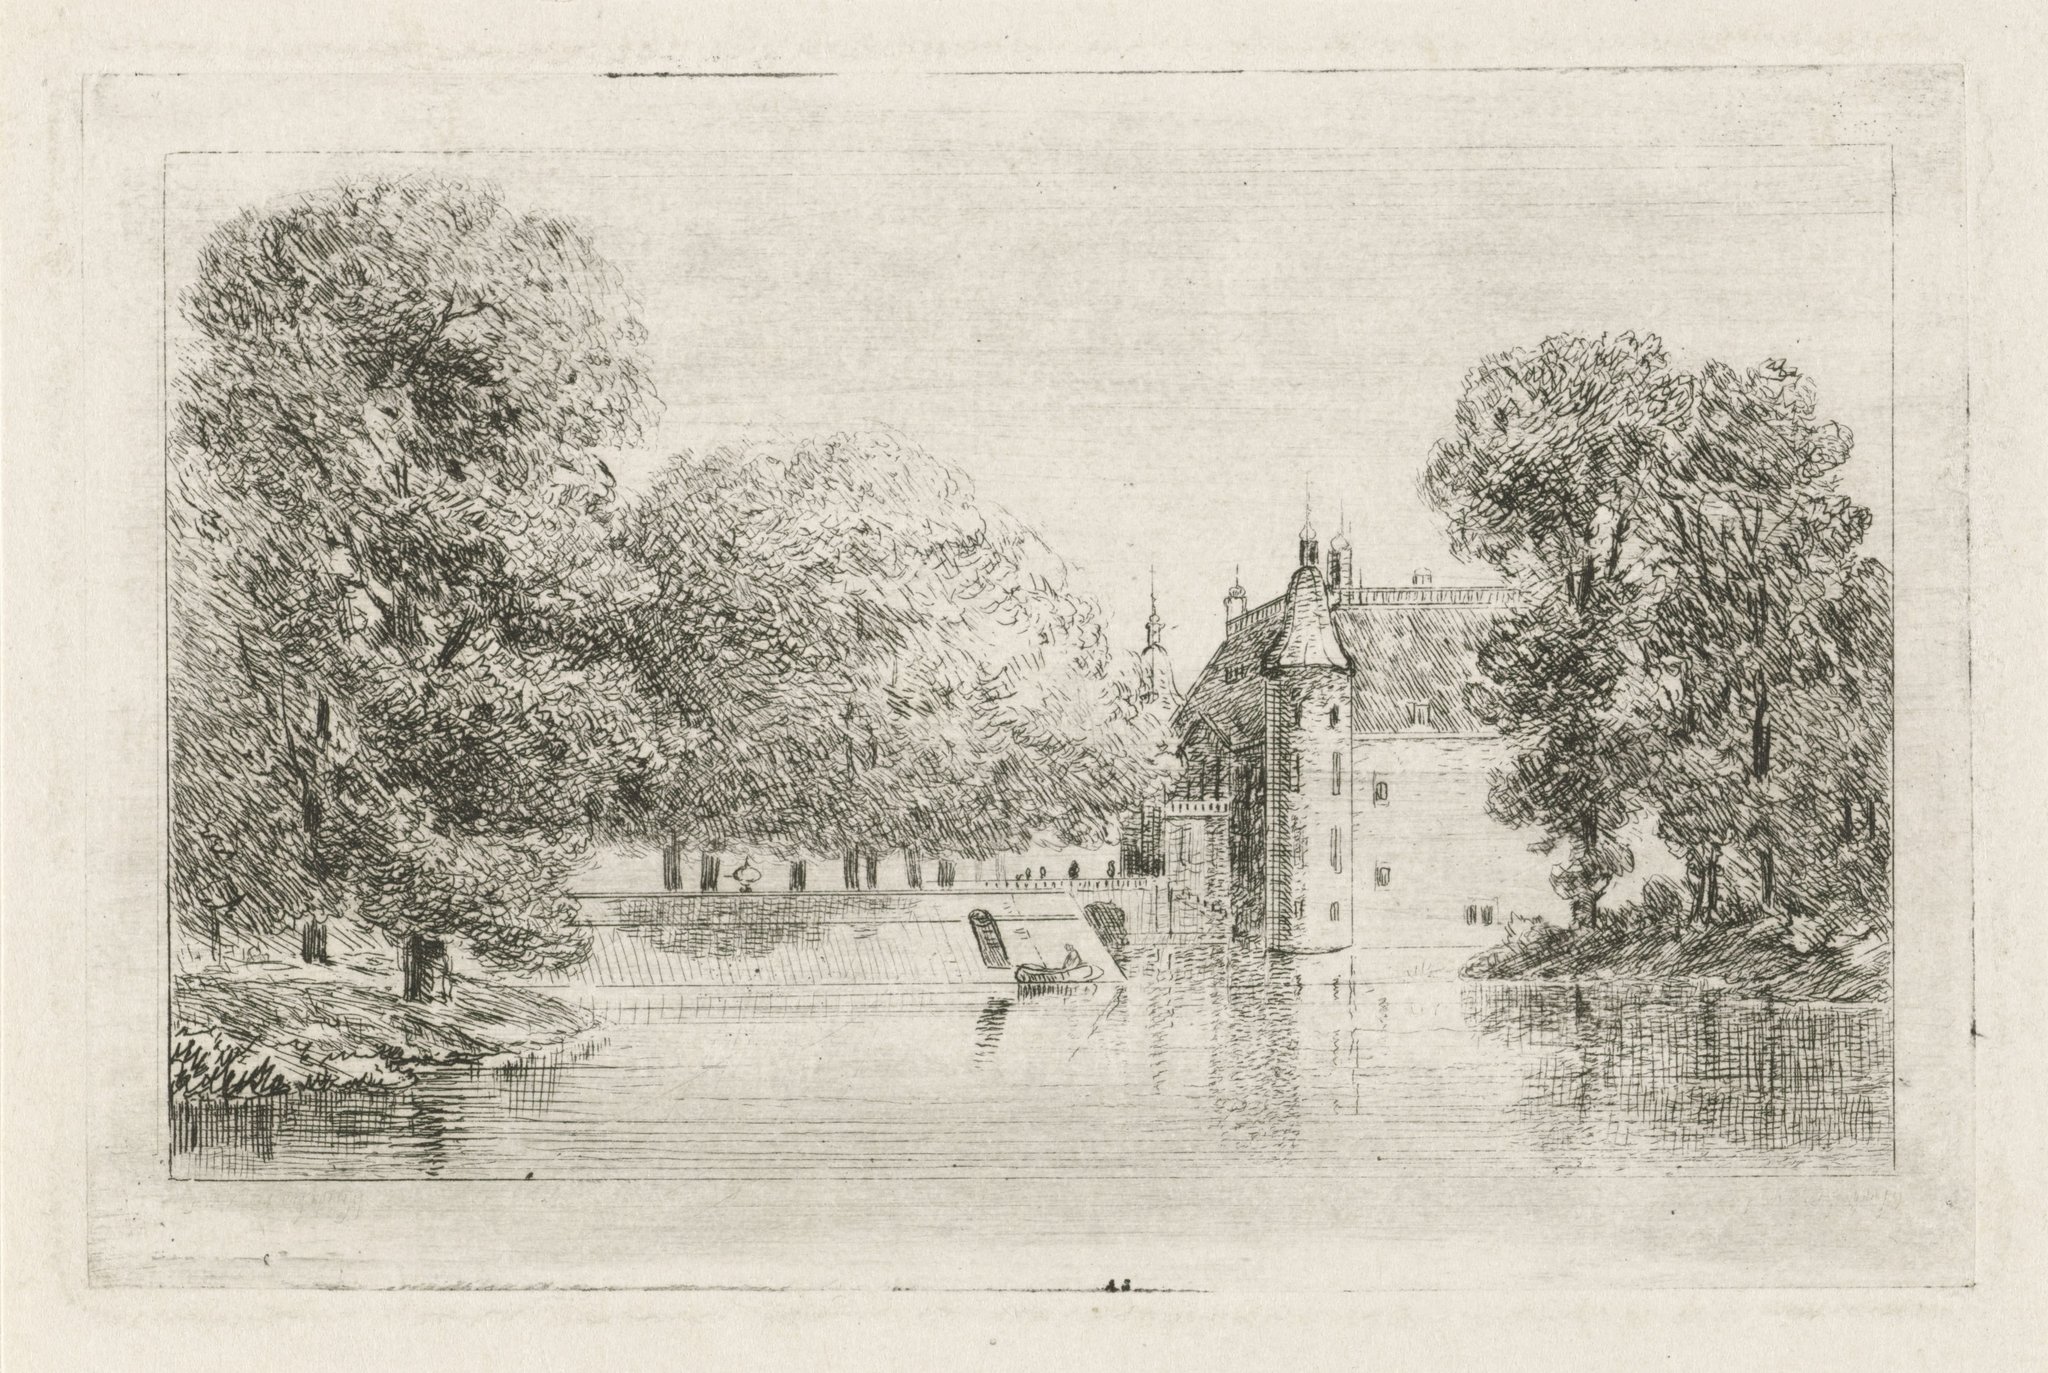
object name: print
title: Gezicht op een kasteel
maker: hermanus jan hendrik van rijkelijkhuysen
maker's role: painter, print maker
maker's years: 1813-1883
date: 1823-1883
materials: paper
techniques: etching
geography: utrecht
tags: castle, rowing-boat, canoe, etc.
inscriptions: collector's mark: Lugt 2228